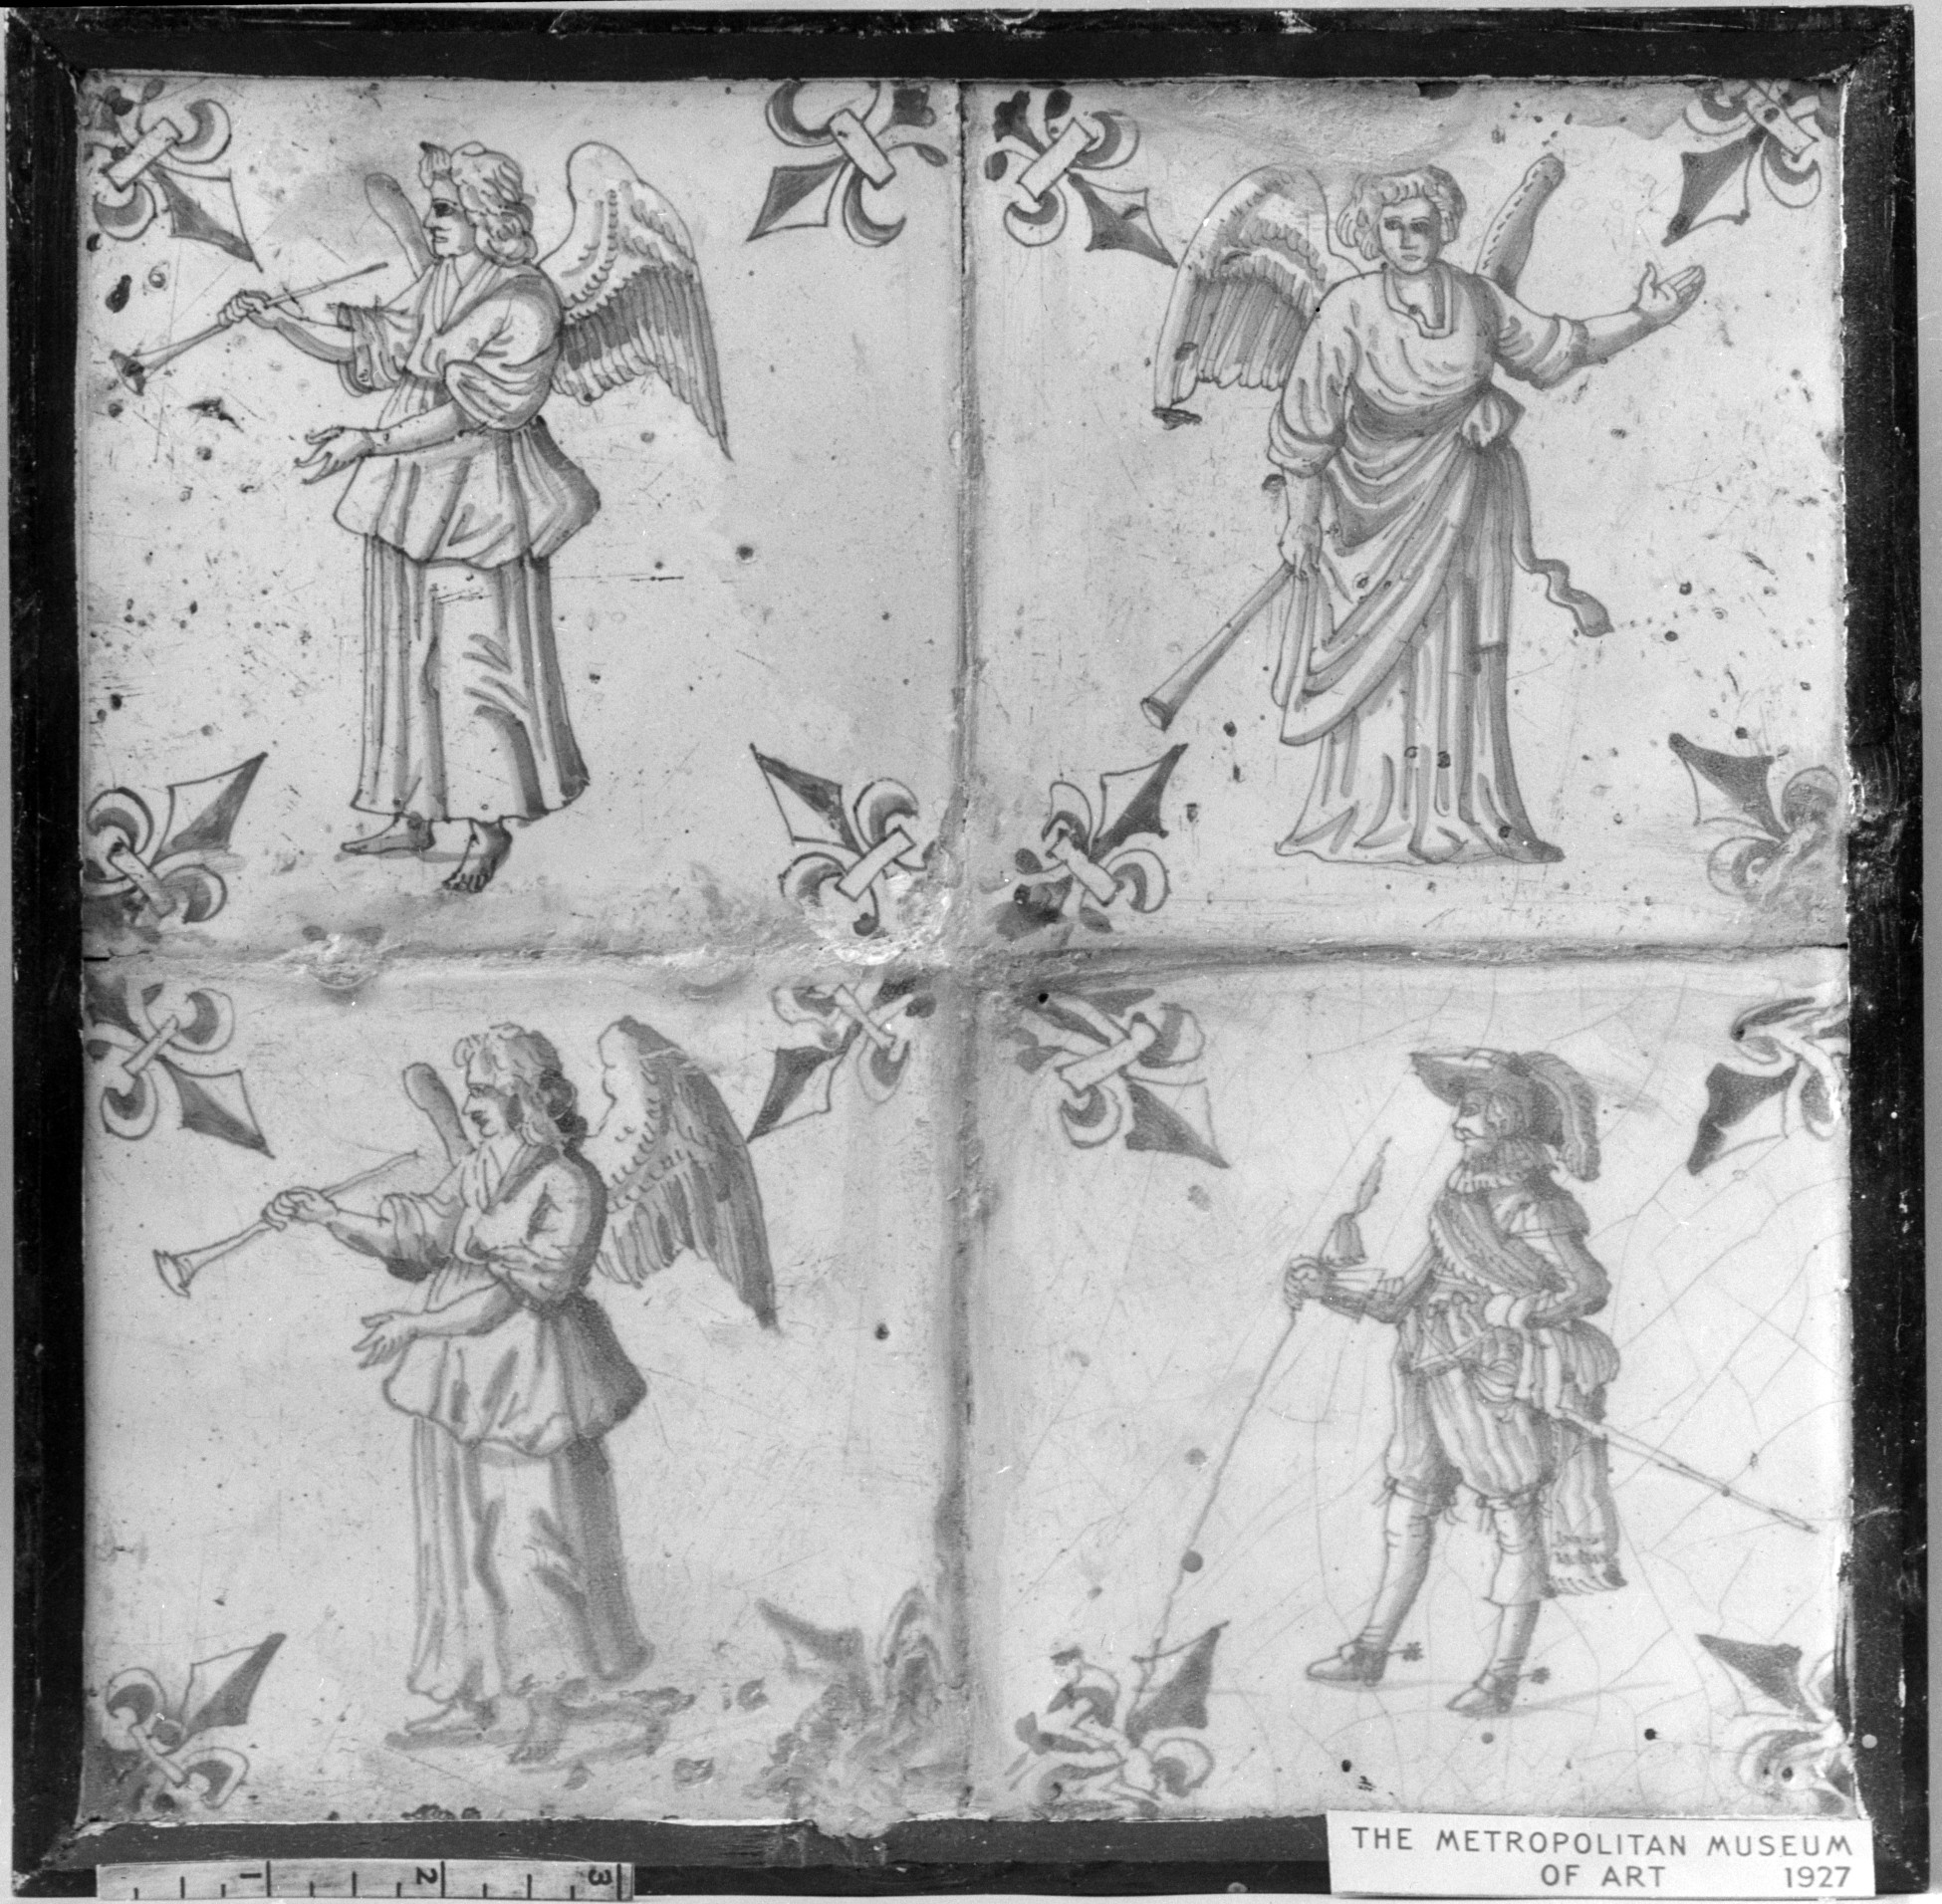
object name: tile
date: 1640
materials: earthenware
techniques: glazing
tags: men,angels